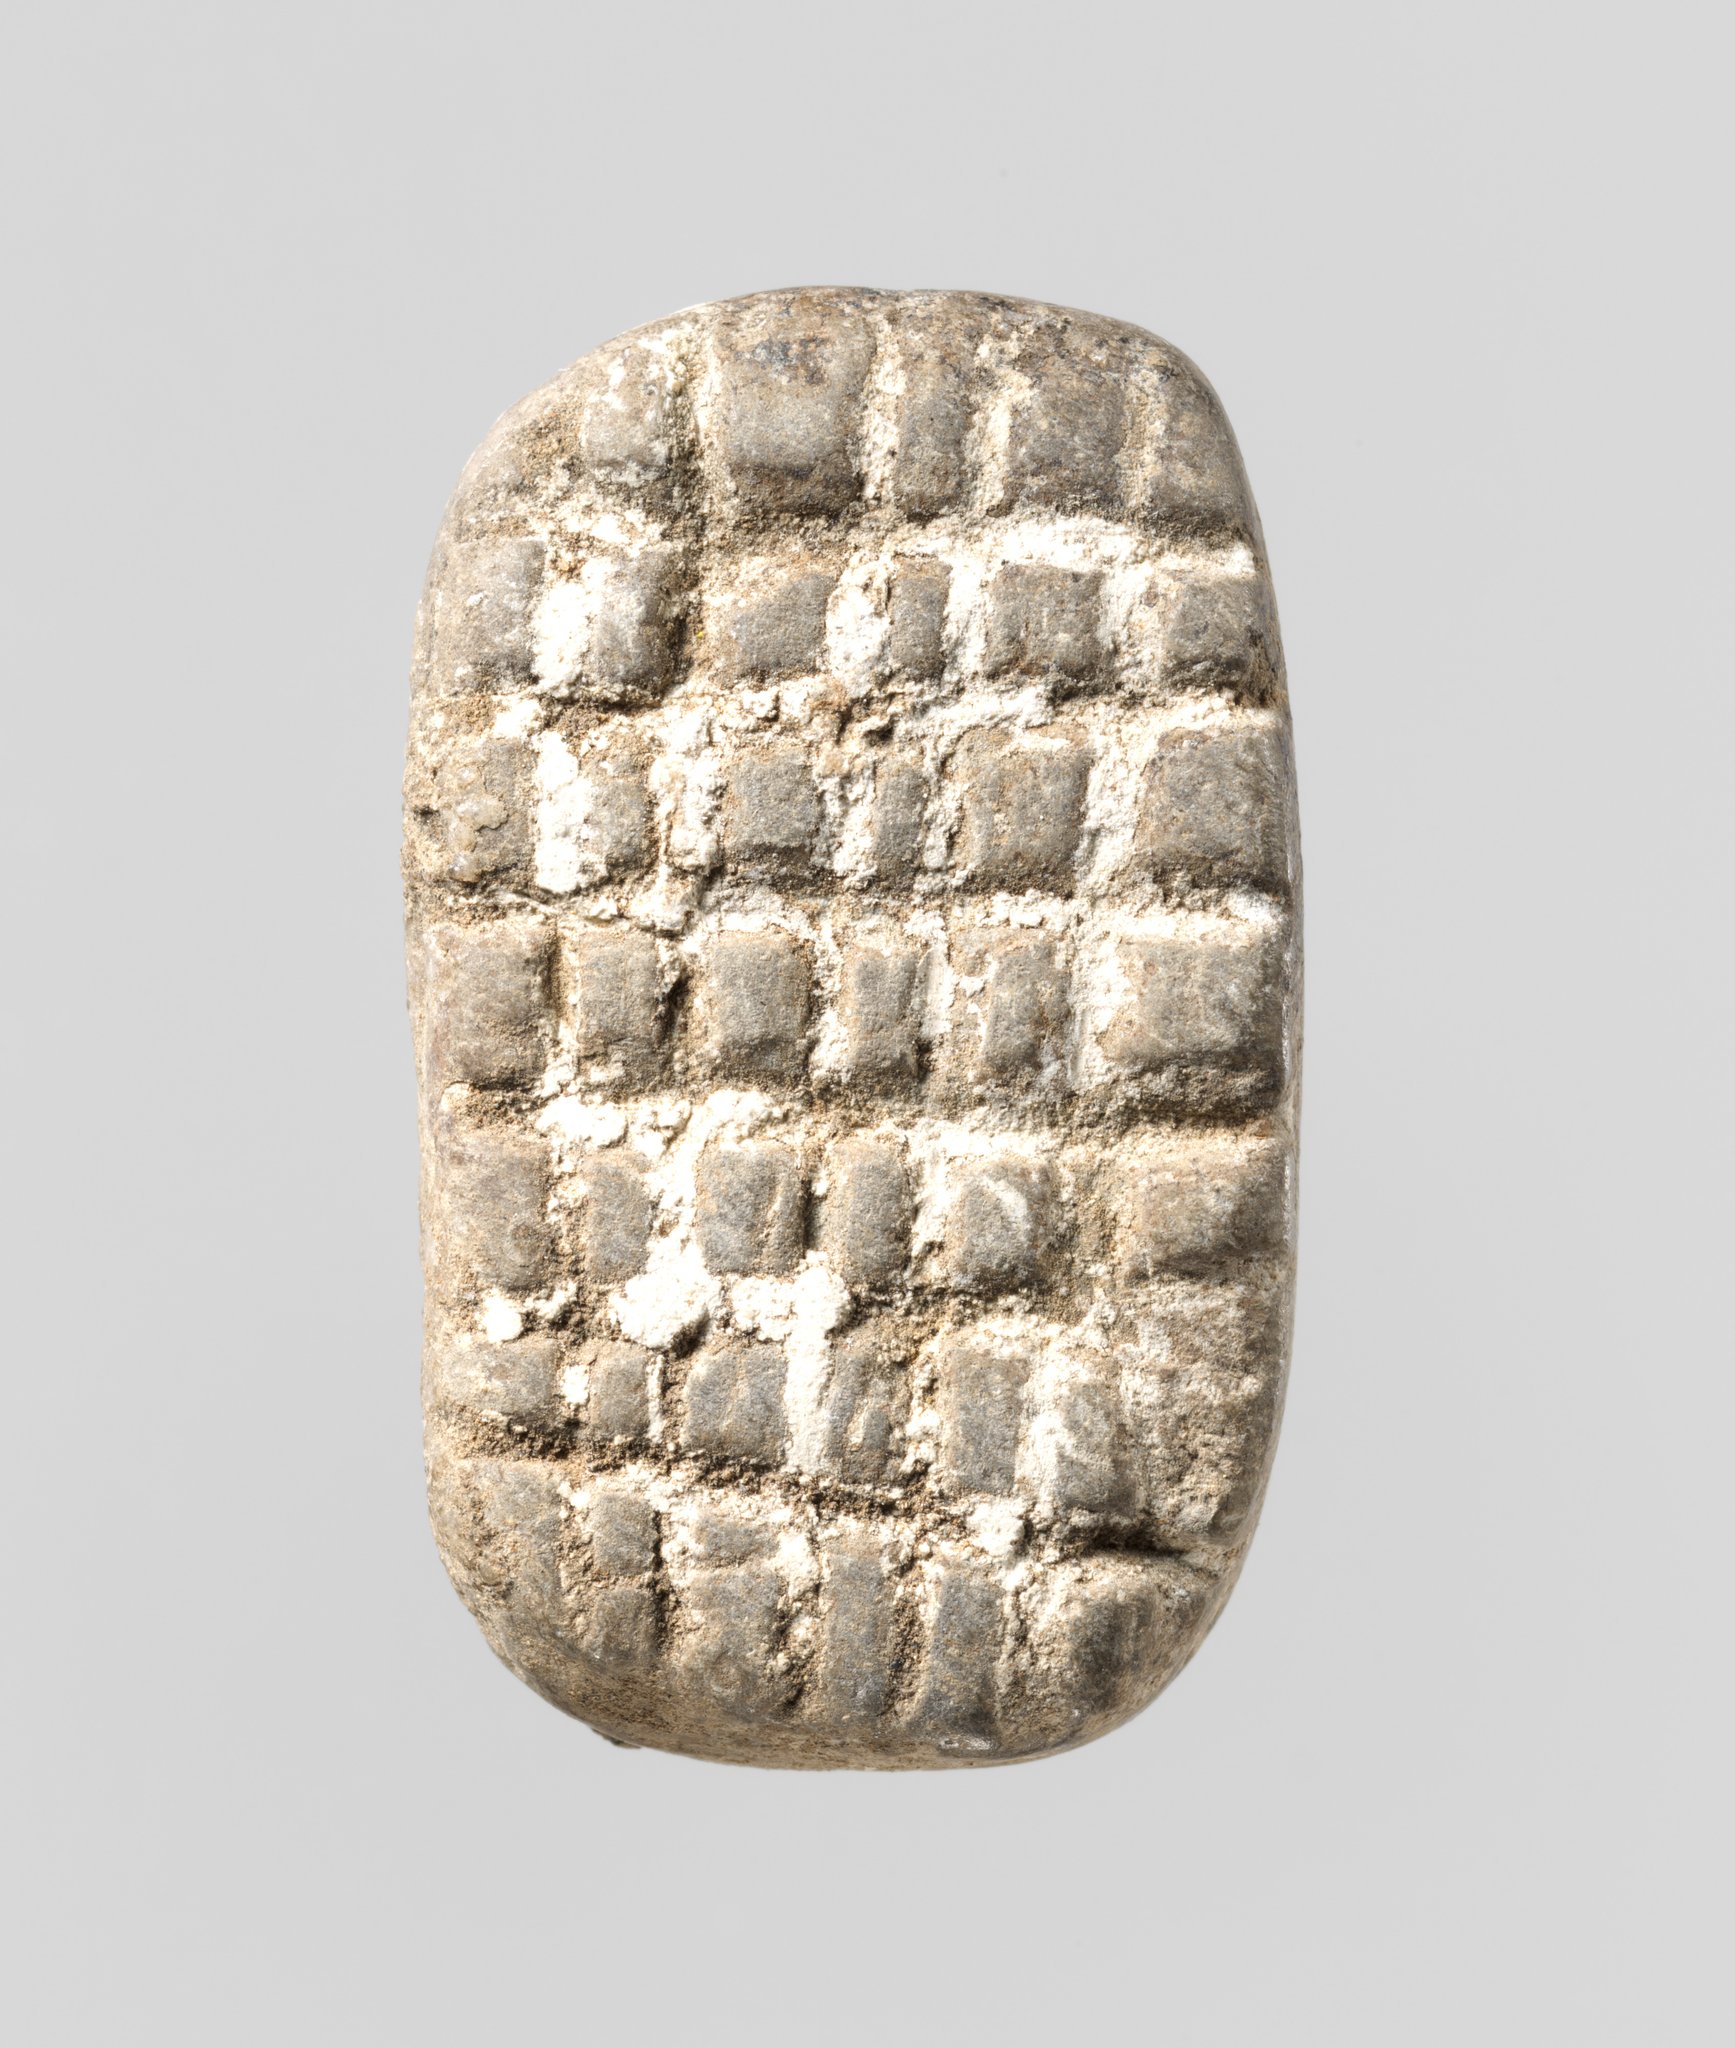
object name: stamp seal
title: Stamp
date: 1295-1070 BCE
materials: limestone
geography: egypt